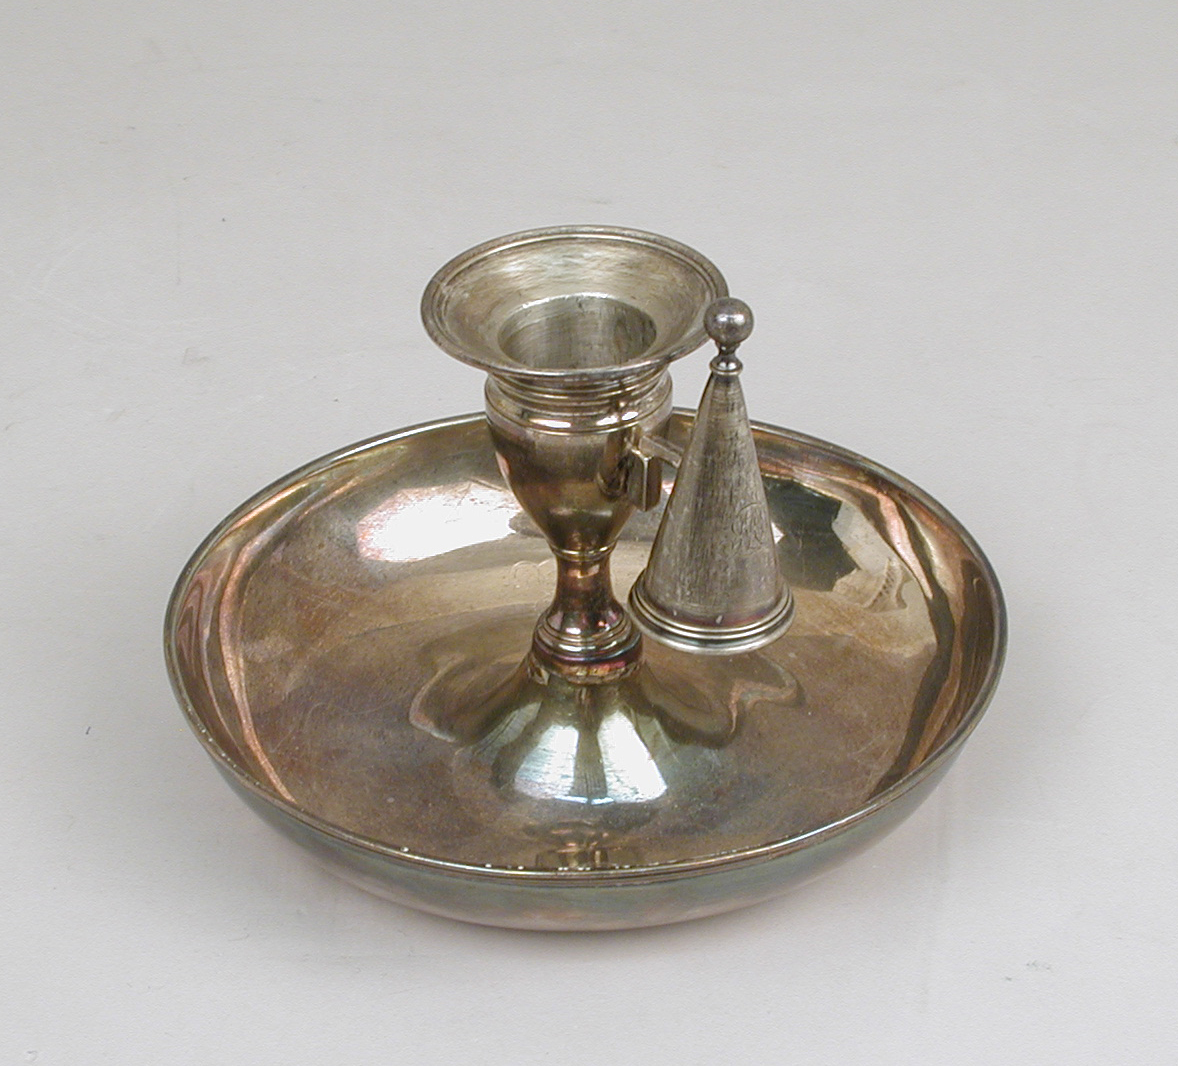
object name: chamber candlestick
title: Chamber candlestick (one of a pair)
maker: john mewburn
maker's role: maker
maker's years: 1750-1850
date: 1805-1806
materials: silver